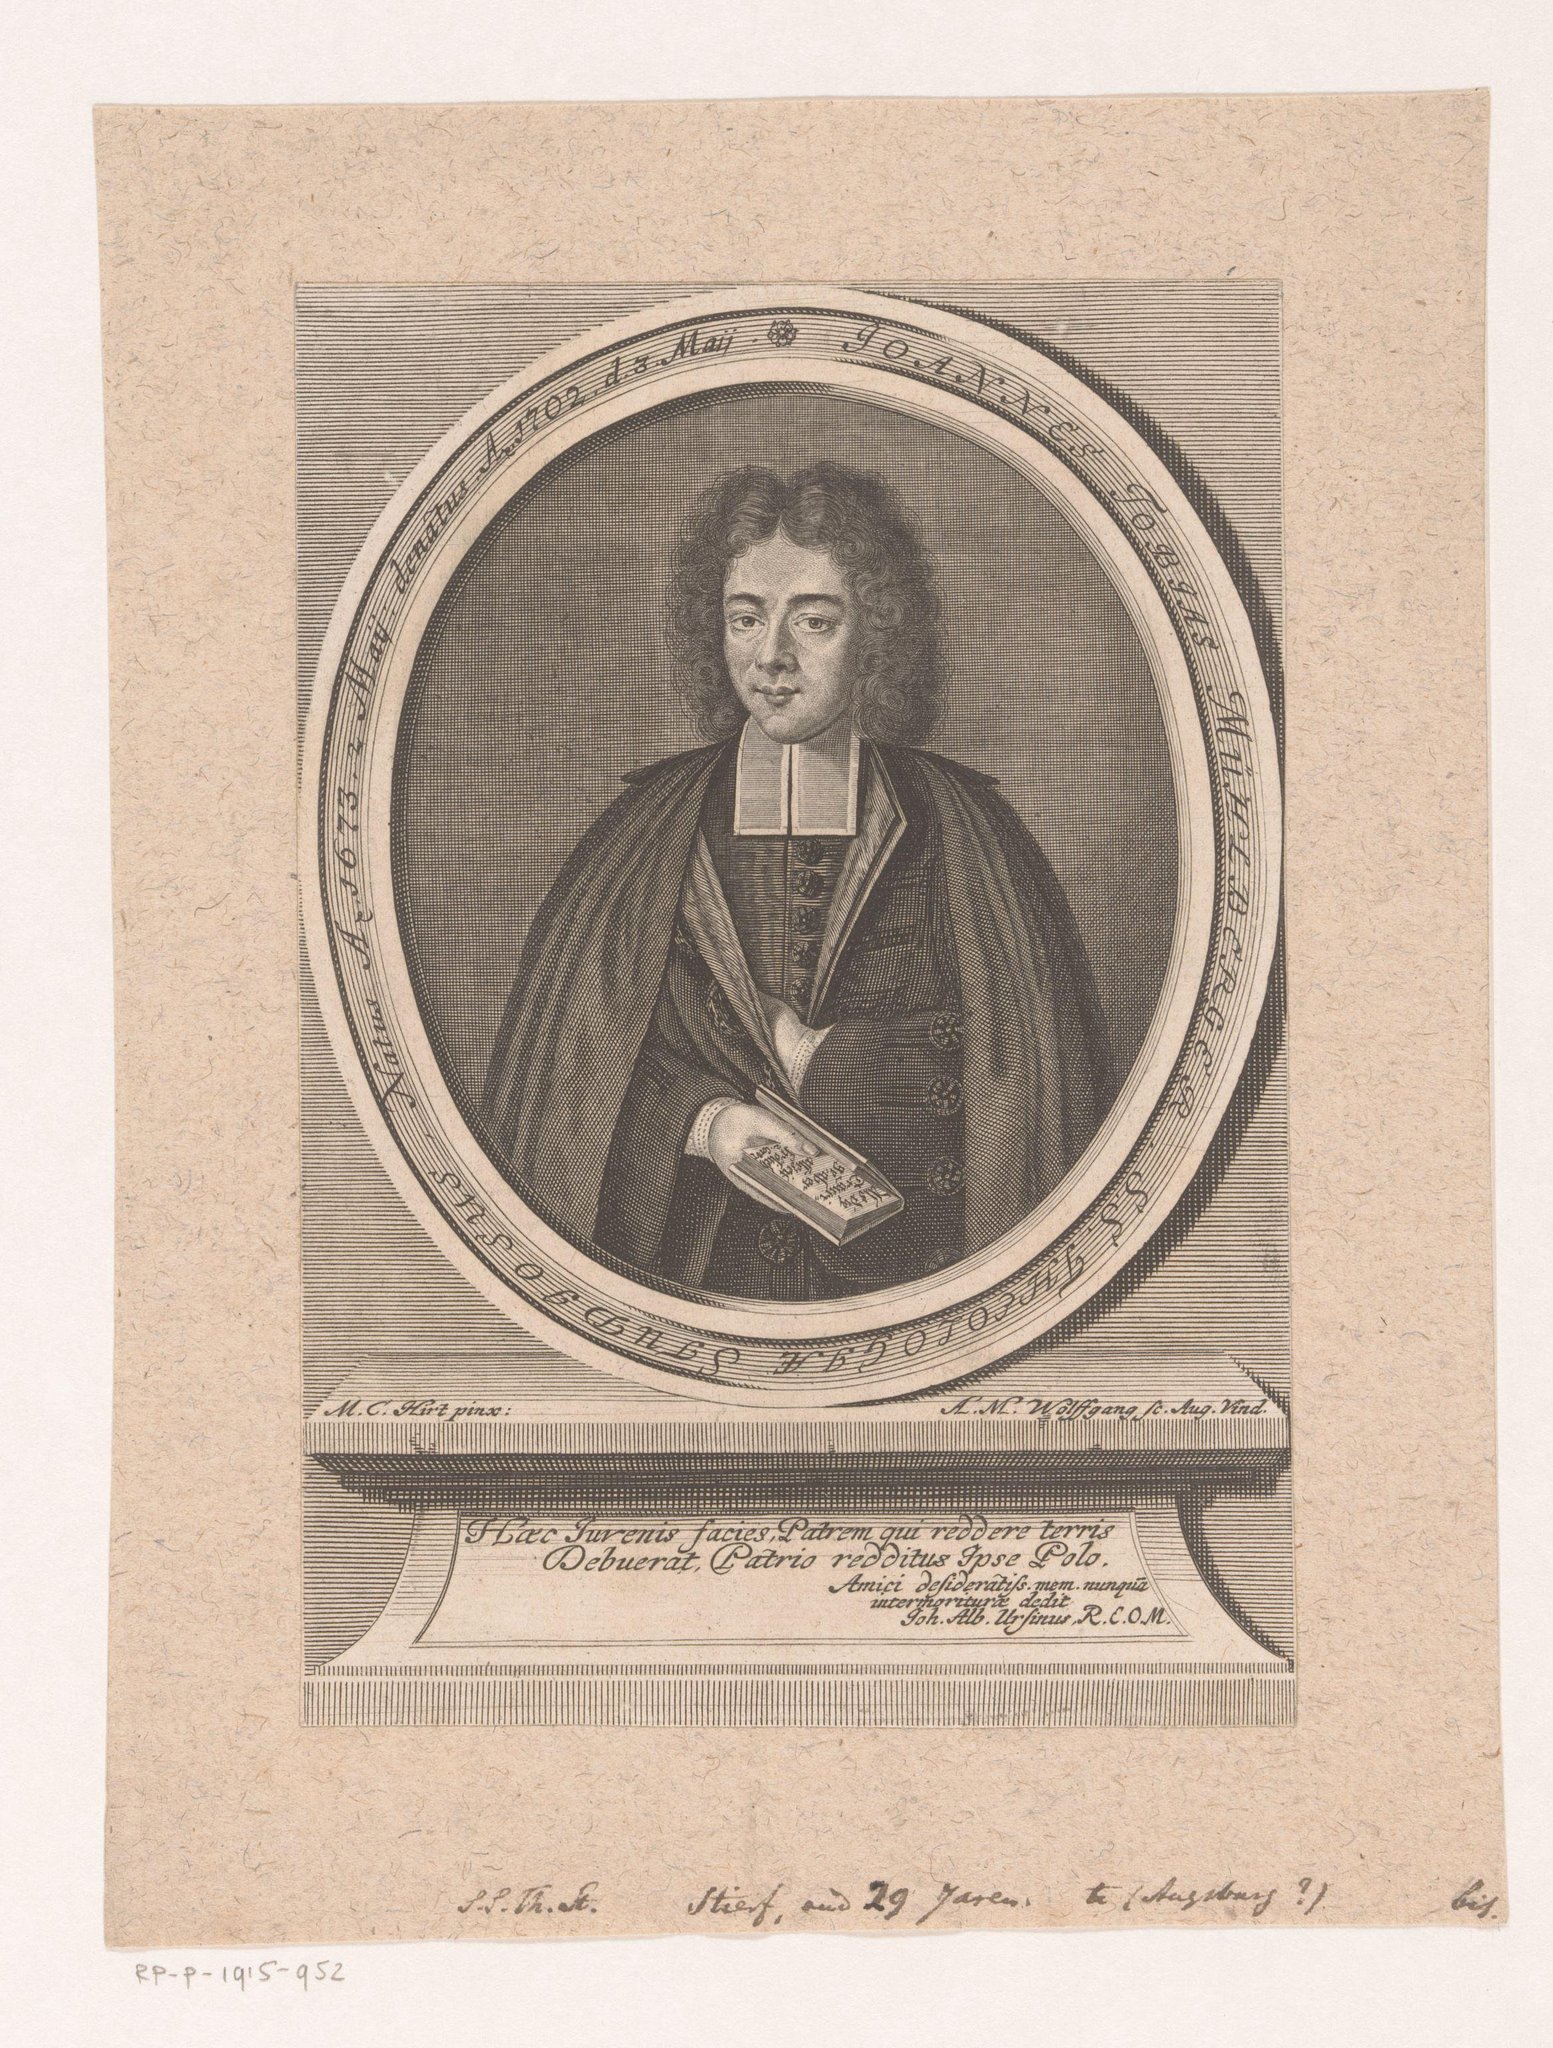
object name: print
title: Portret van Johann Tobias Mühlberger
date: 1702-1737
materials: paper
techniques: engraving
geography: augsburg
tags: historical persons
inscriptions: collector's mark: Lugt 2228, collector's mark: Lugt 9